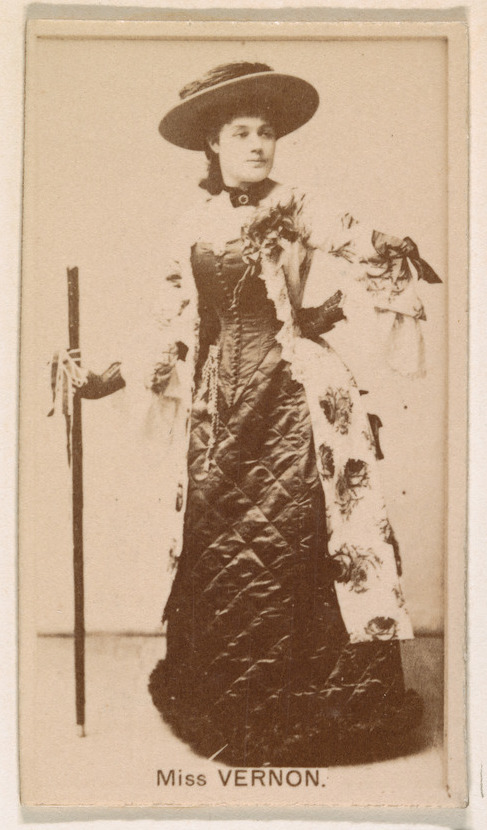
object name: photograph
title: Miss Vernon, from the Actresses series (N245) issued by Kinney Brothers to promote Sweet Caporal Cigarettes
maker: kinney brothers tobacco company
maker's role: publisher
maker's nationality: american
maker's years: 1869-2011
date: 1890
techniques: albumen silver print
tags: portraits,women,actresses